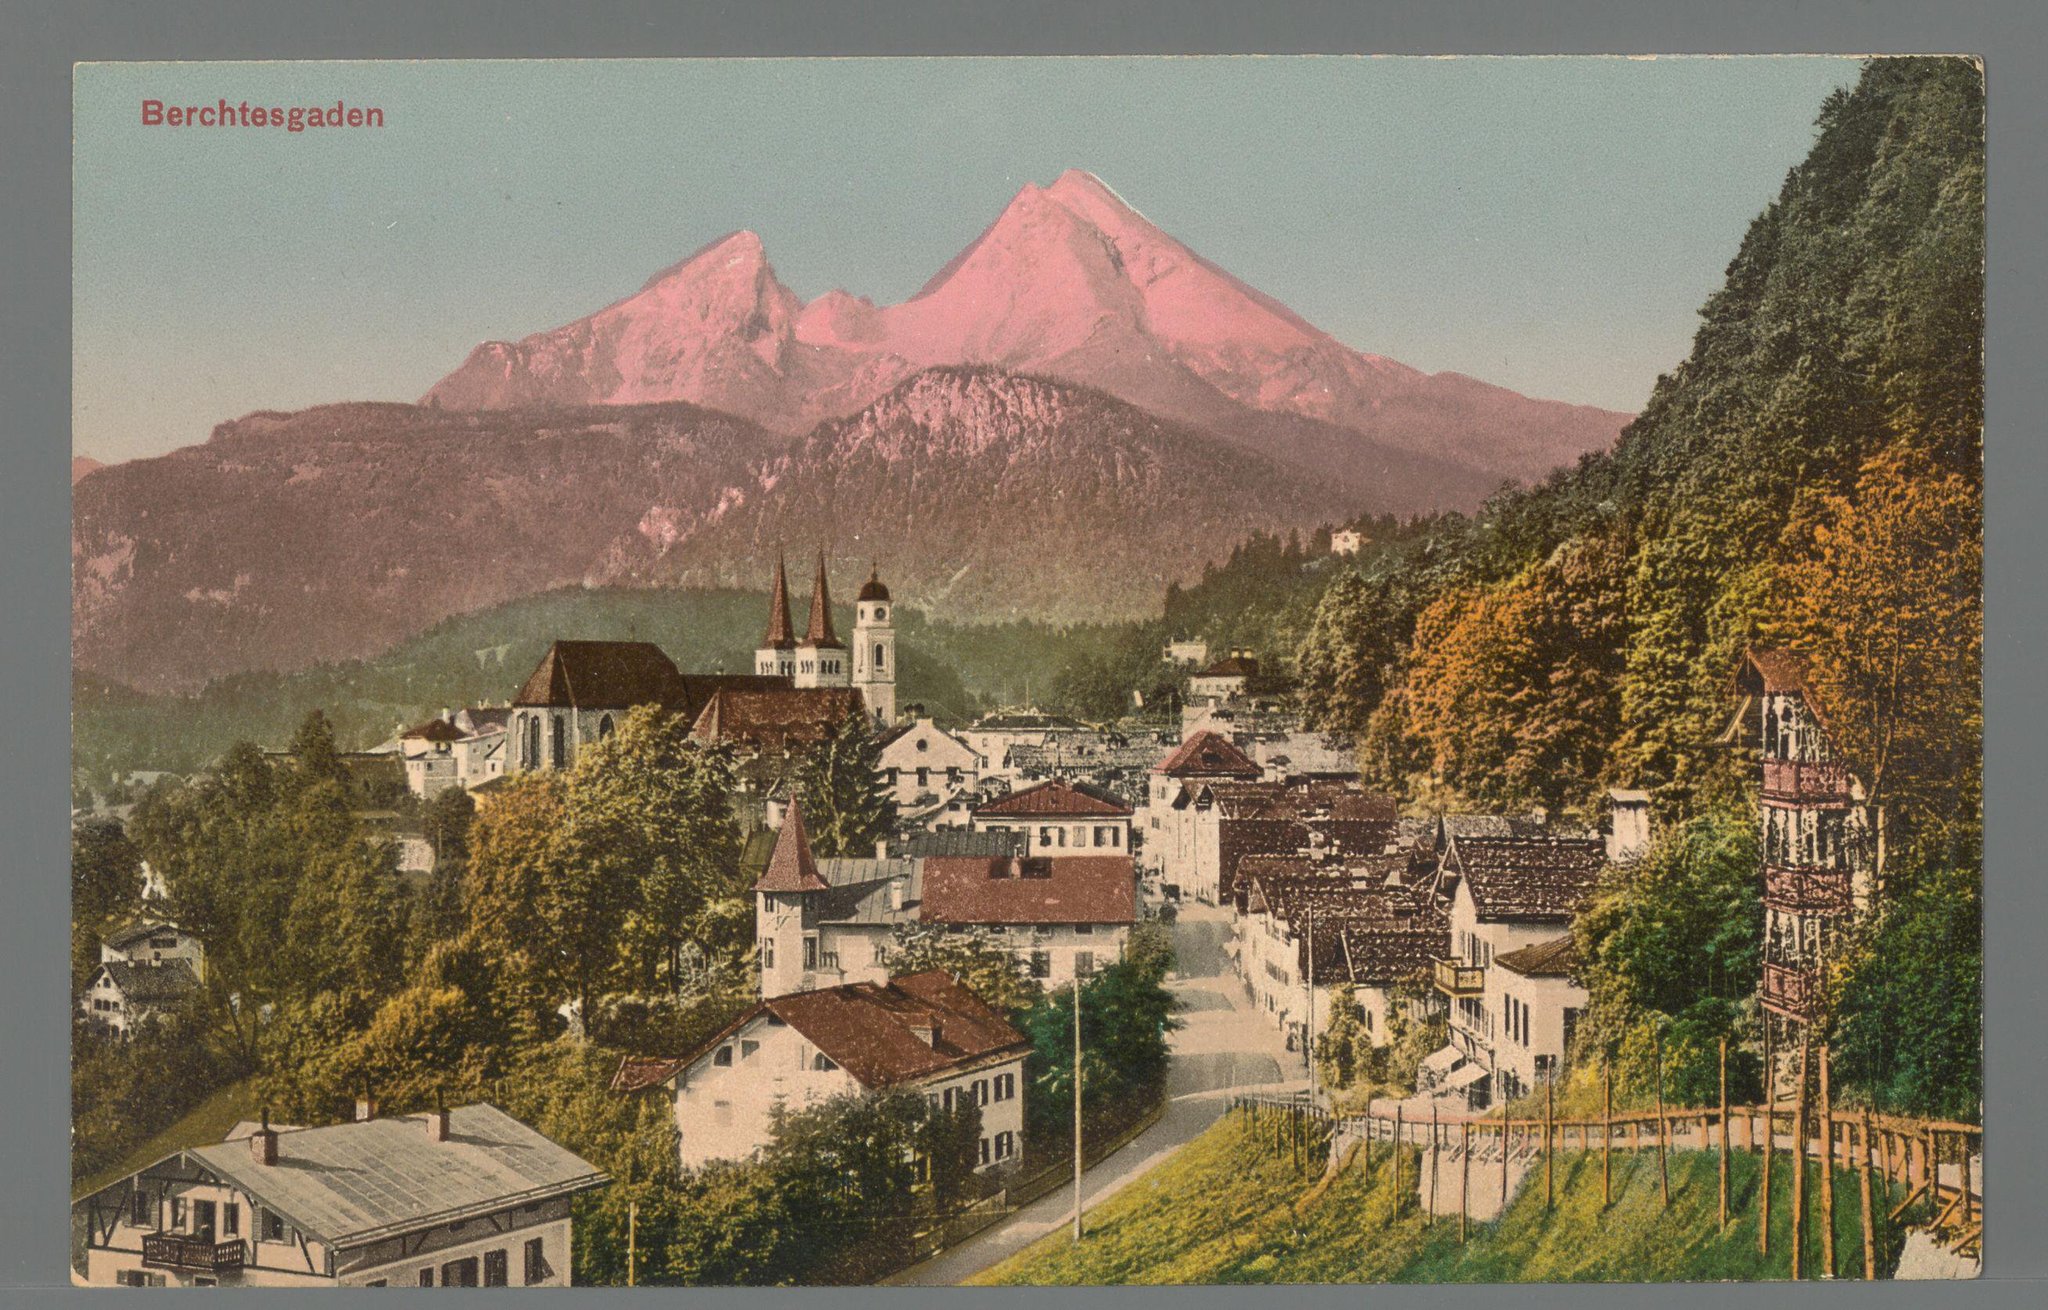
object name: photomechanical print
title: Berchtesgaden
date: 1904-1930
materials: cardboard, photographic process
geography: munich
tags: church (exterior), mountains